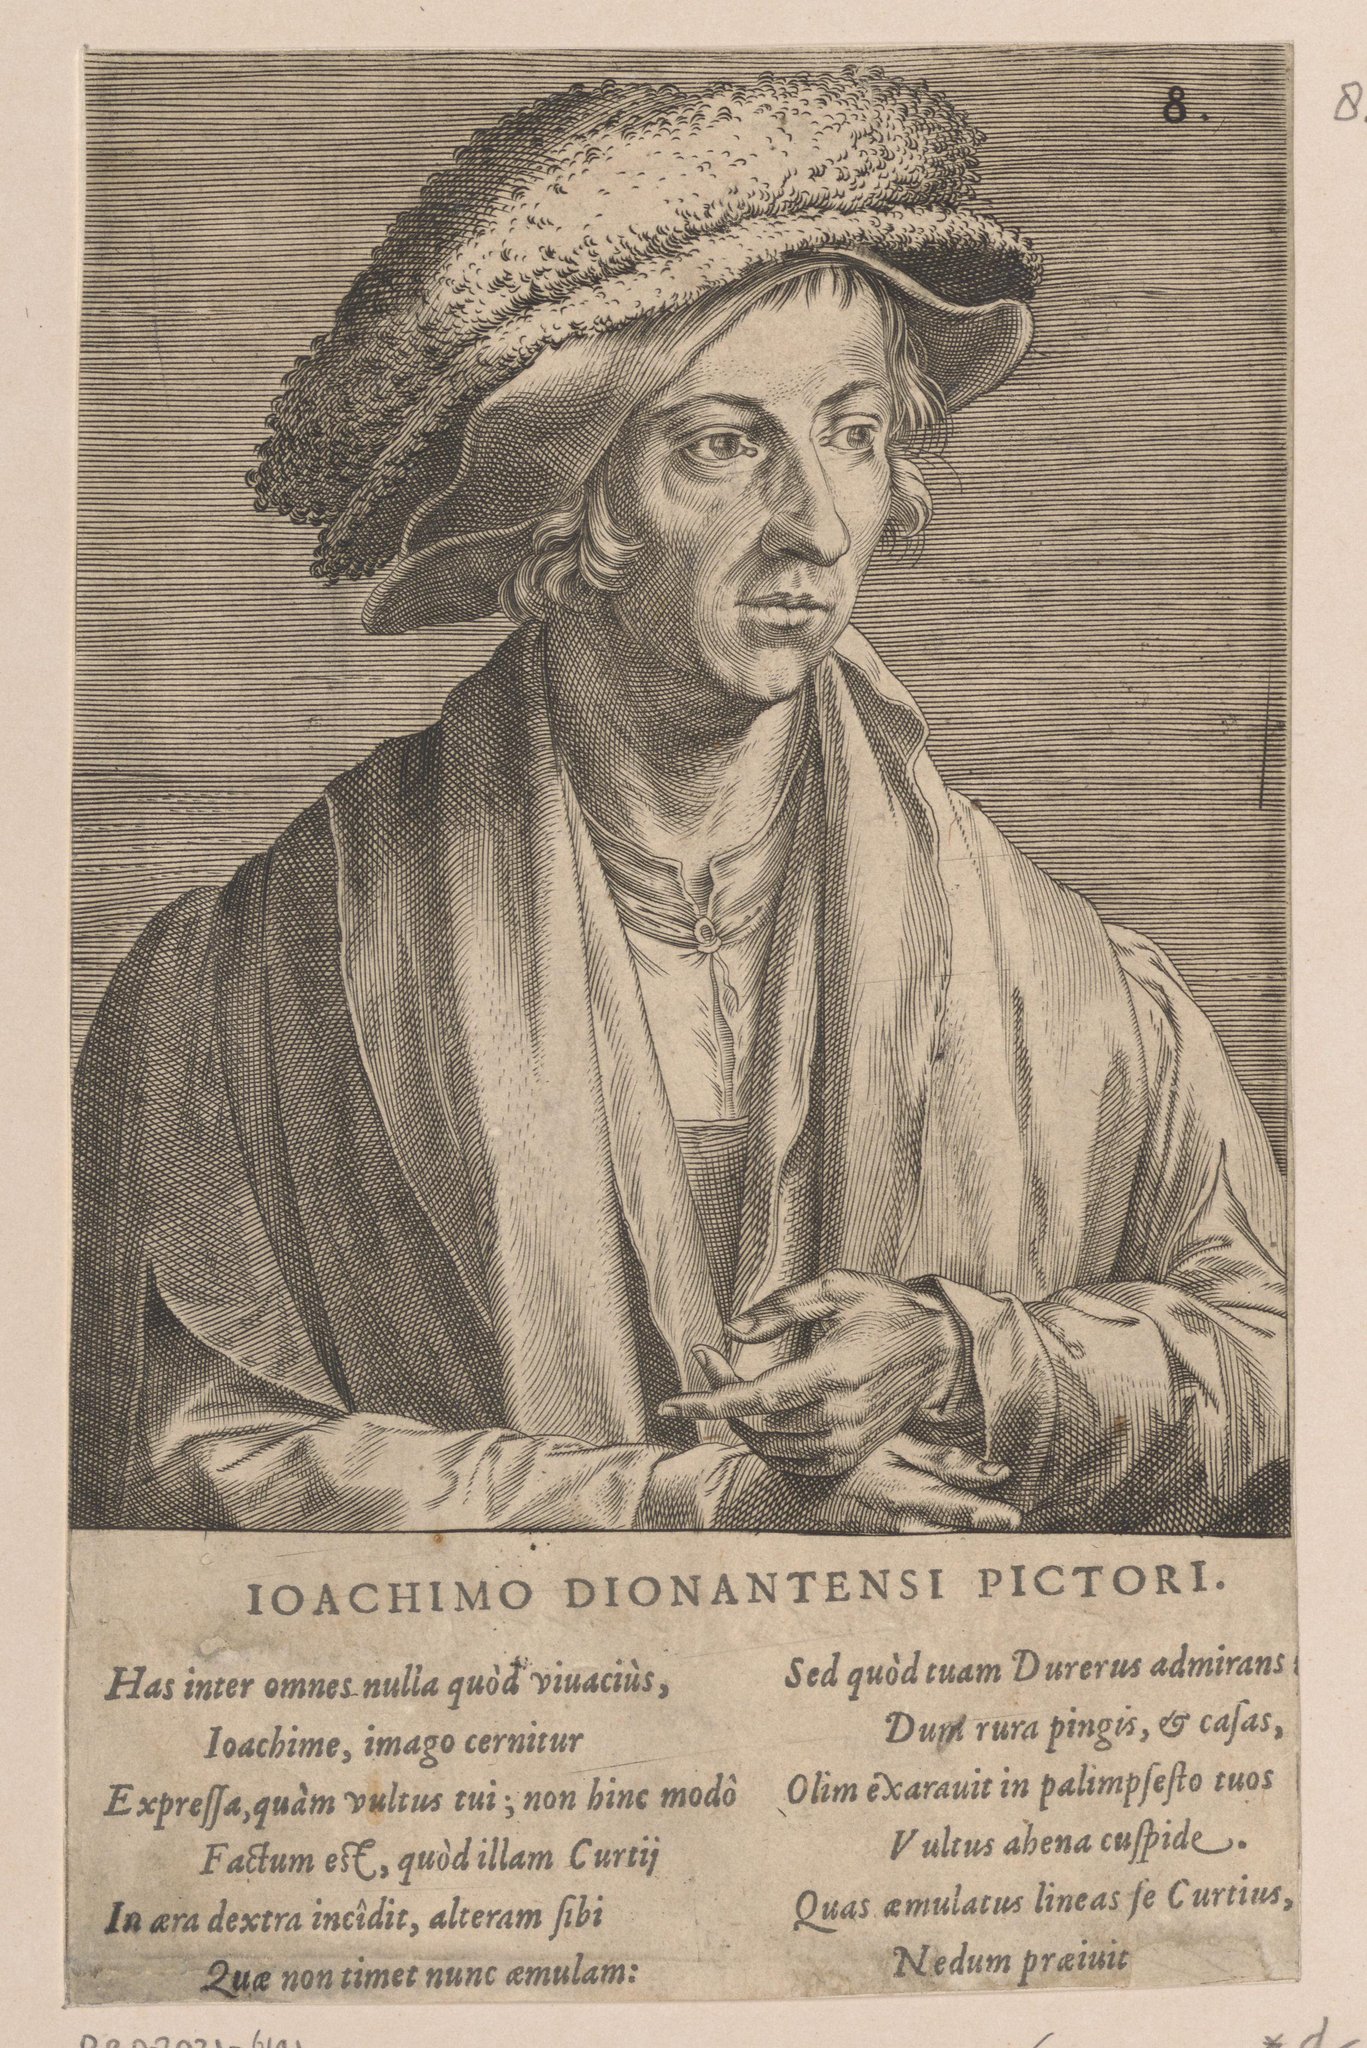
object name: print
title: Pictorum Aliquot Celebrium Germaniae Inferioris Effigies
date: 1572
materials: paper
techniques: engraving, letterpress printing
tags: antwerp, painter, draughtsman, joachim patinir, adult man, historical persons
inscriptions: collector's mark: Lugt 2165